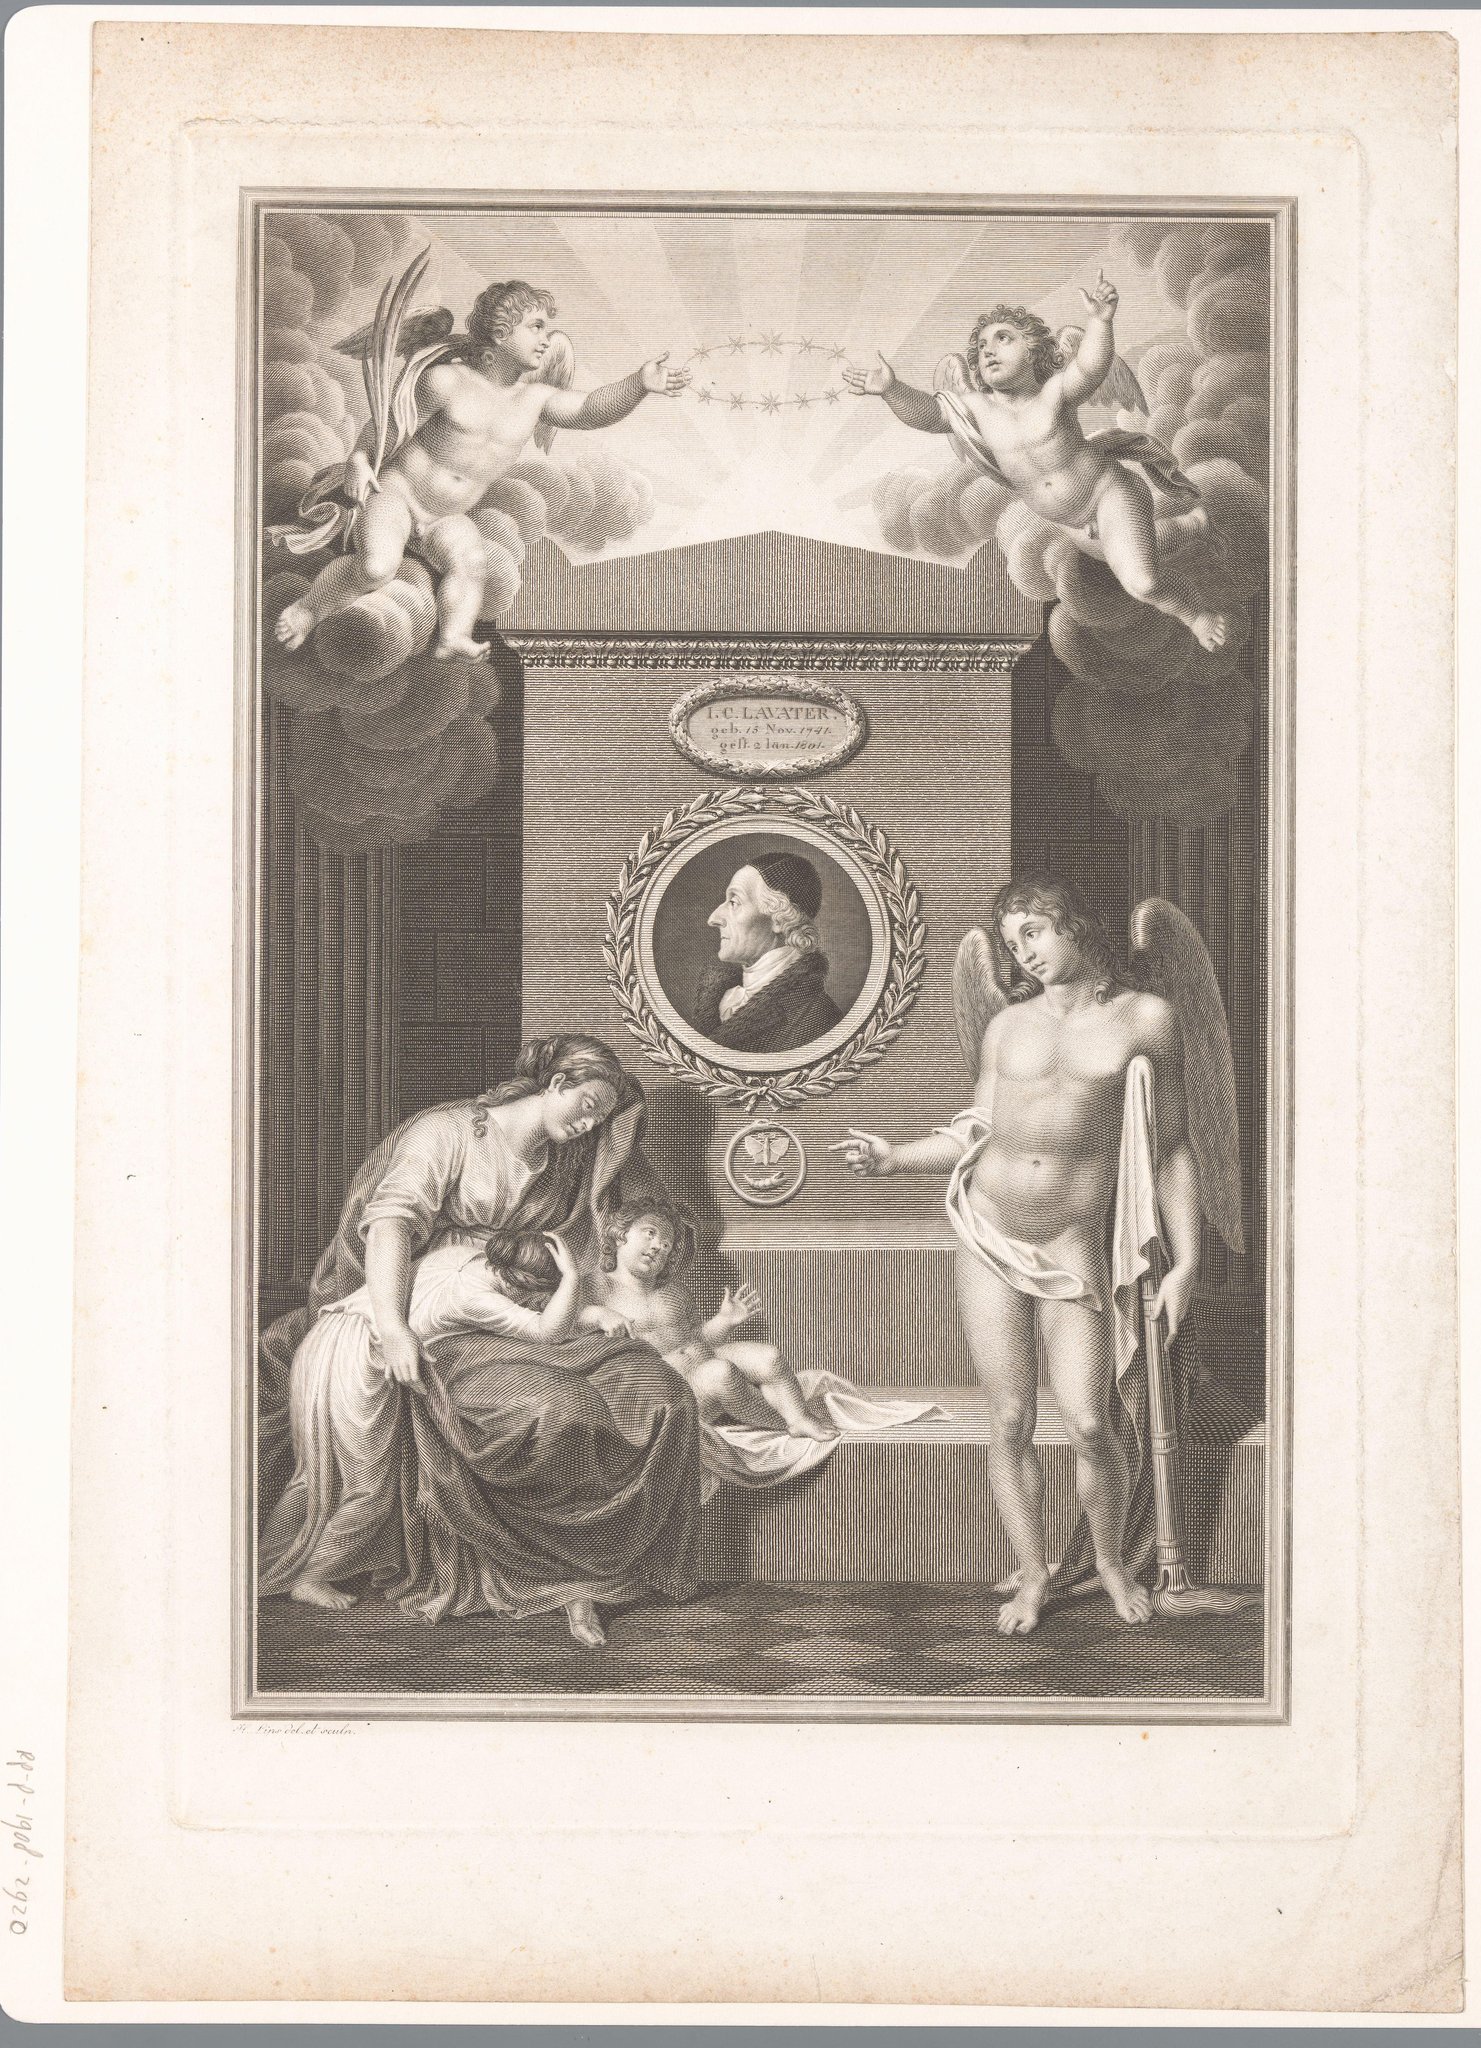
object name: print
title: Grafmonument met portret van Johann Kaspar Lavater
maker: johann heinrich lips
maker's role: draughtsman, painter, print maker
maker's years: 1758-1817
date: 1801-1817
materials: paper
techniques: engraving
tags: johann caspar lavater, historical persons, portrait of a writer, grave-building, monumental tomb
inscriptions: collector's mark: Lugt 2228